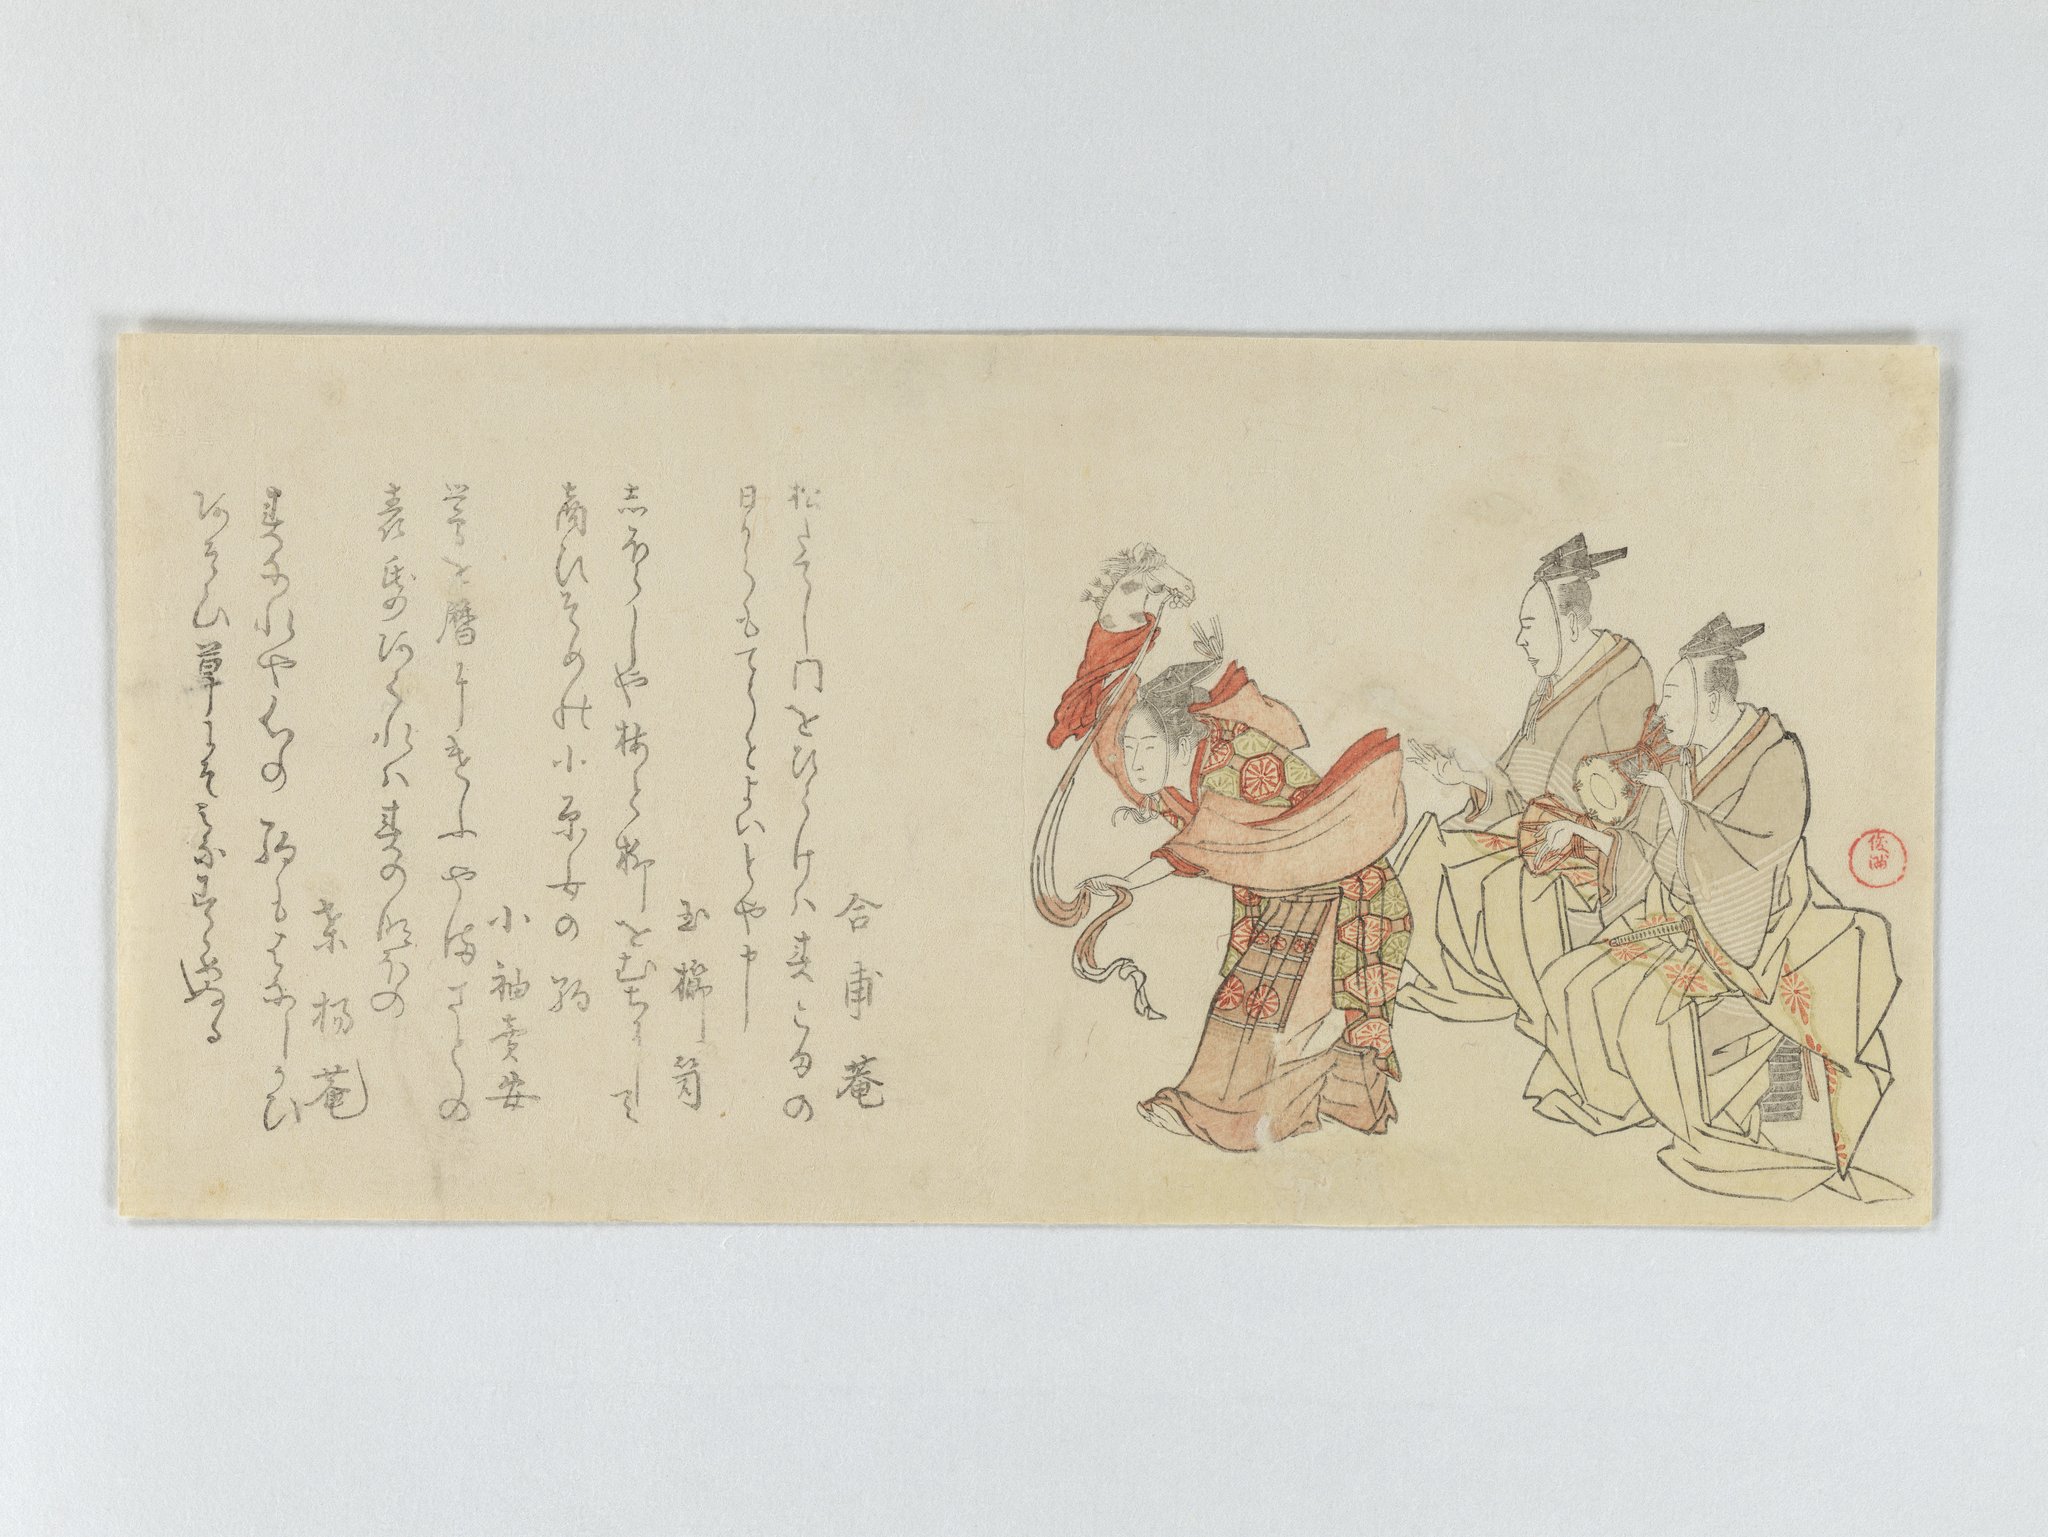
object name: woodblock print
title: Dancer with Hobby Horse and Two Musicians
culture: japanese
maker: kubo shunman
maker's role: artist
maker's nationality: japanese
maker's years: 1757-1820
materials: ink, paper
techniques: surimono, woodblock print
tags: dancing,drums,dancers,musicians